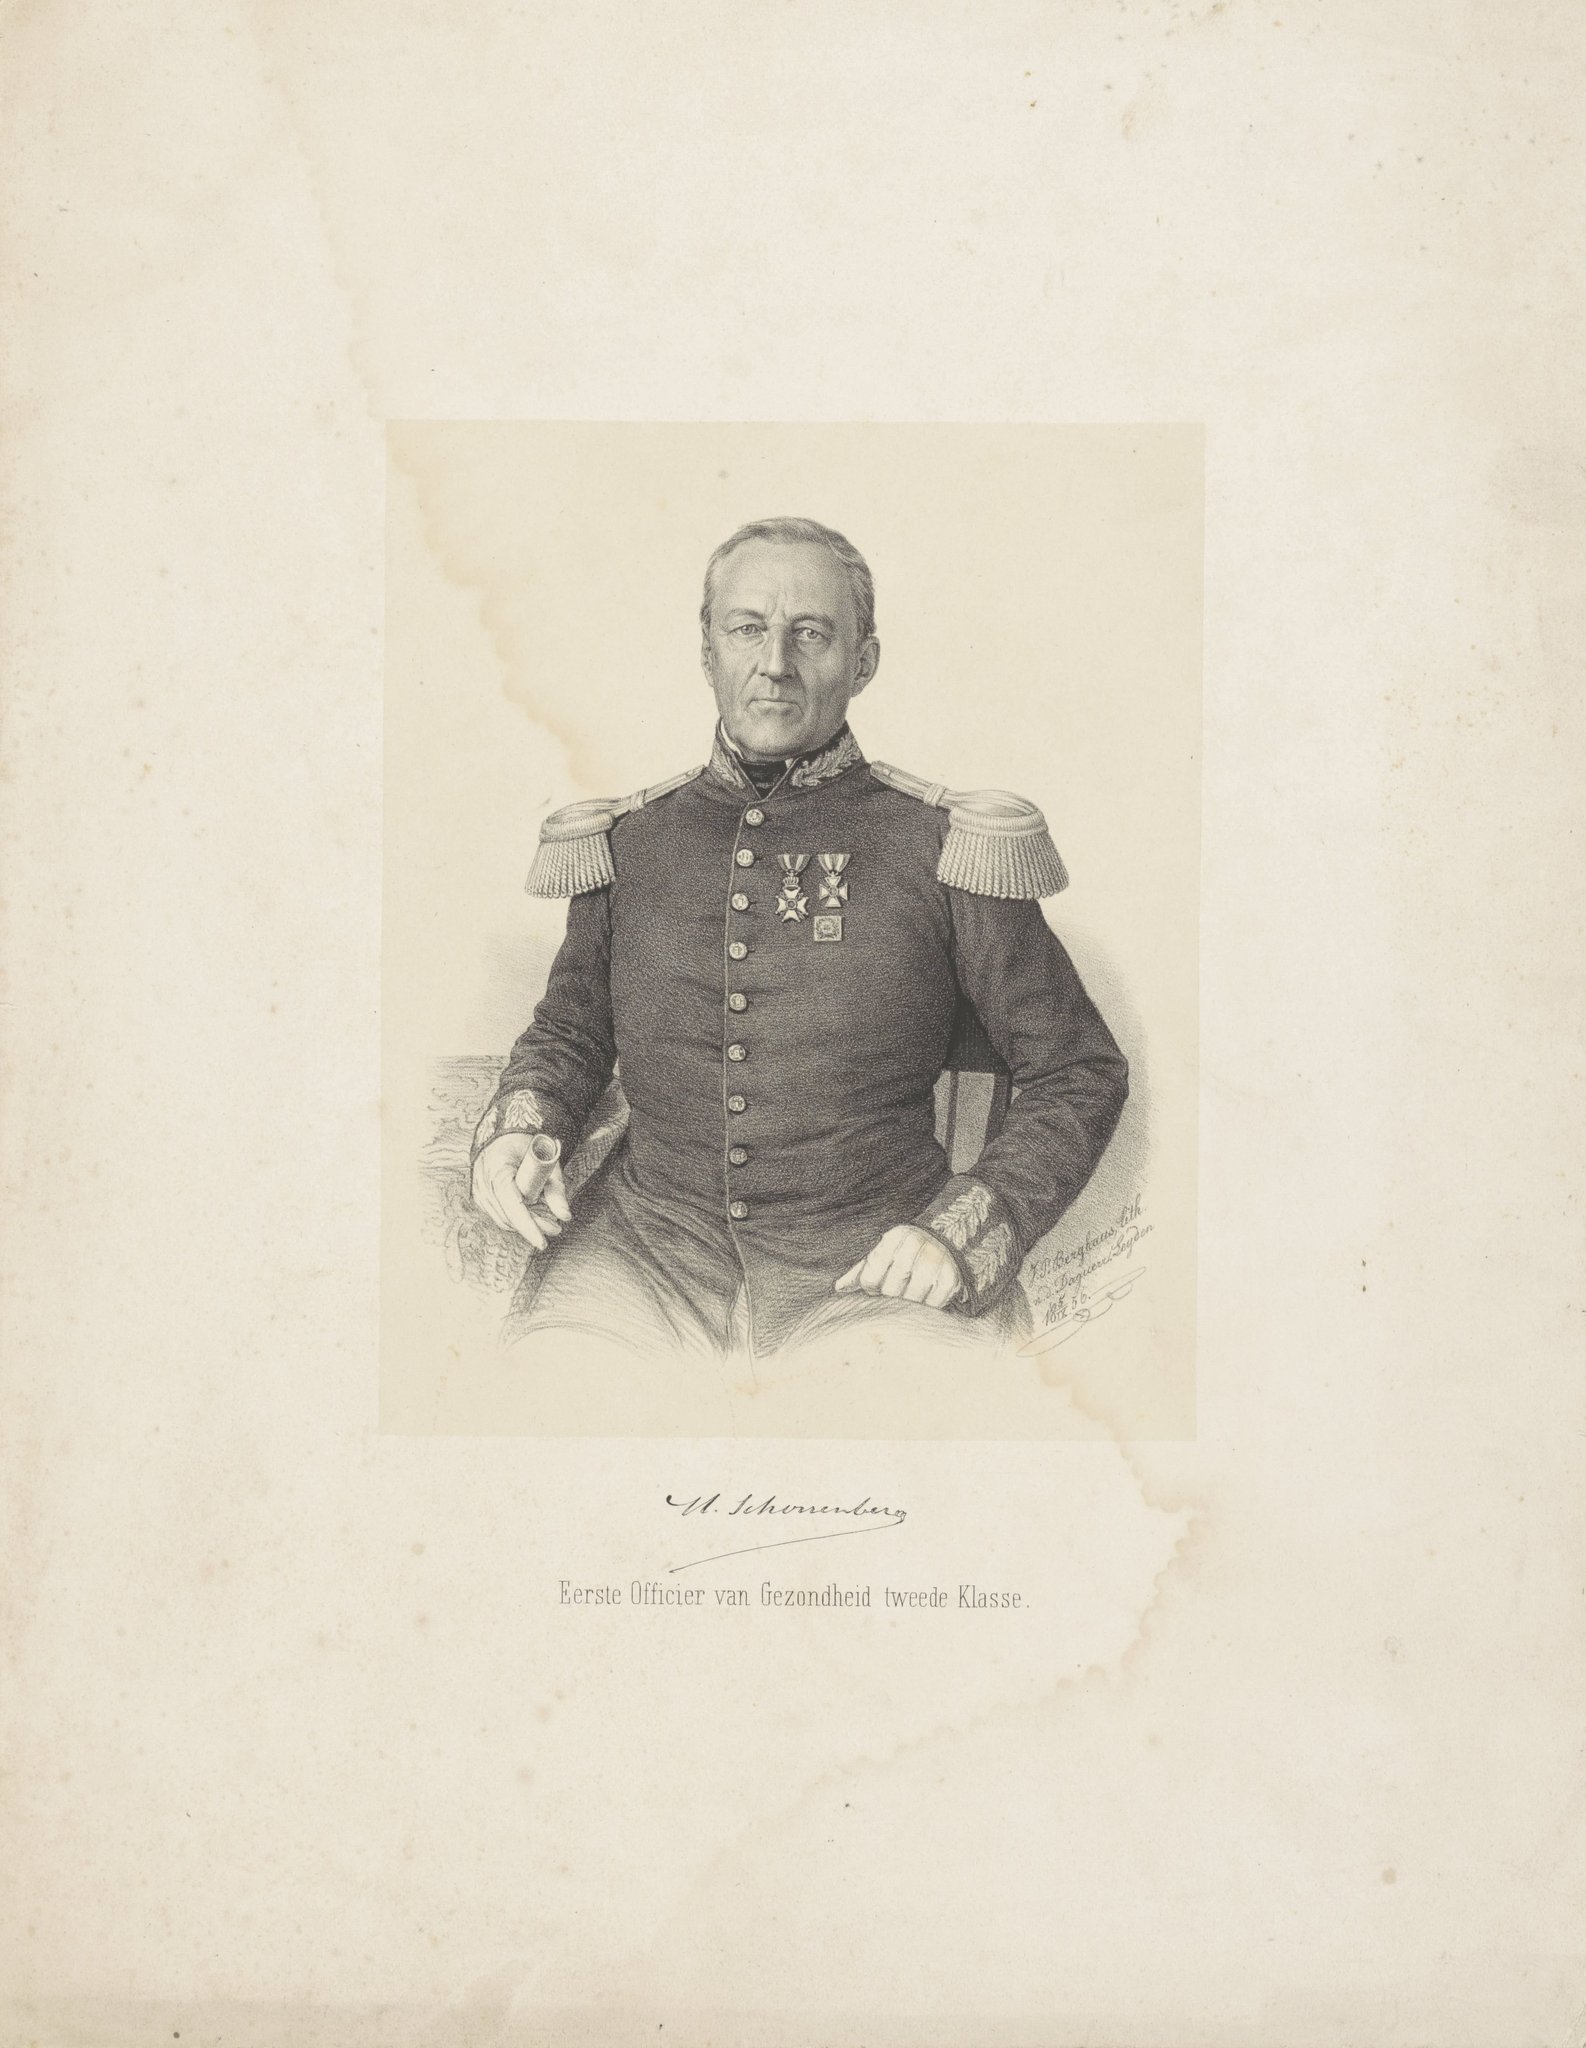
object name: print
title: Portret van M. Schonenberg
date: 1856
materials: paper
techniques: lithograph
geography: leiden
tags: knighthood order, historical persons, paper (writing material)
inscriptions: collector's mark: Lugt 2228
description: De geportretteerde draagt een militair uniform met twee ridderorden op de borst. Hij zit op een stoel naast een tafel met daarop een tafelkleed. In zijn rechterhand heeft hij een opgerold stuk papier. Onder het portret zijn signatuur en functie.